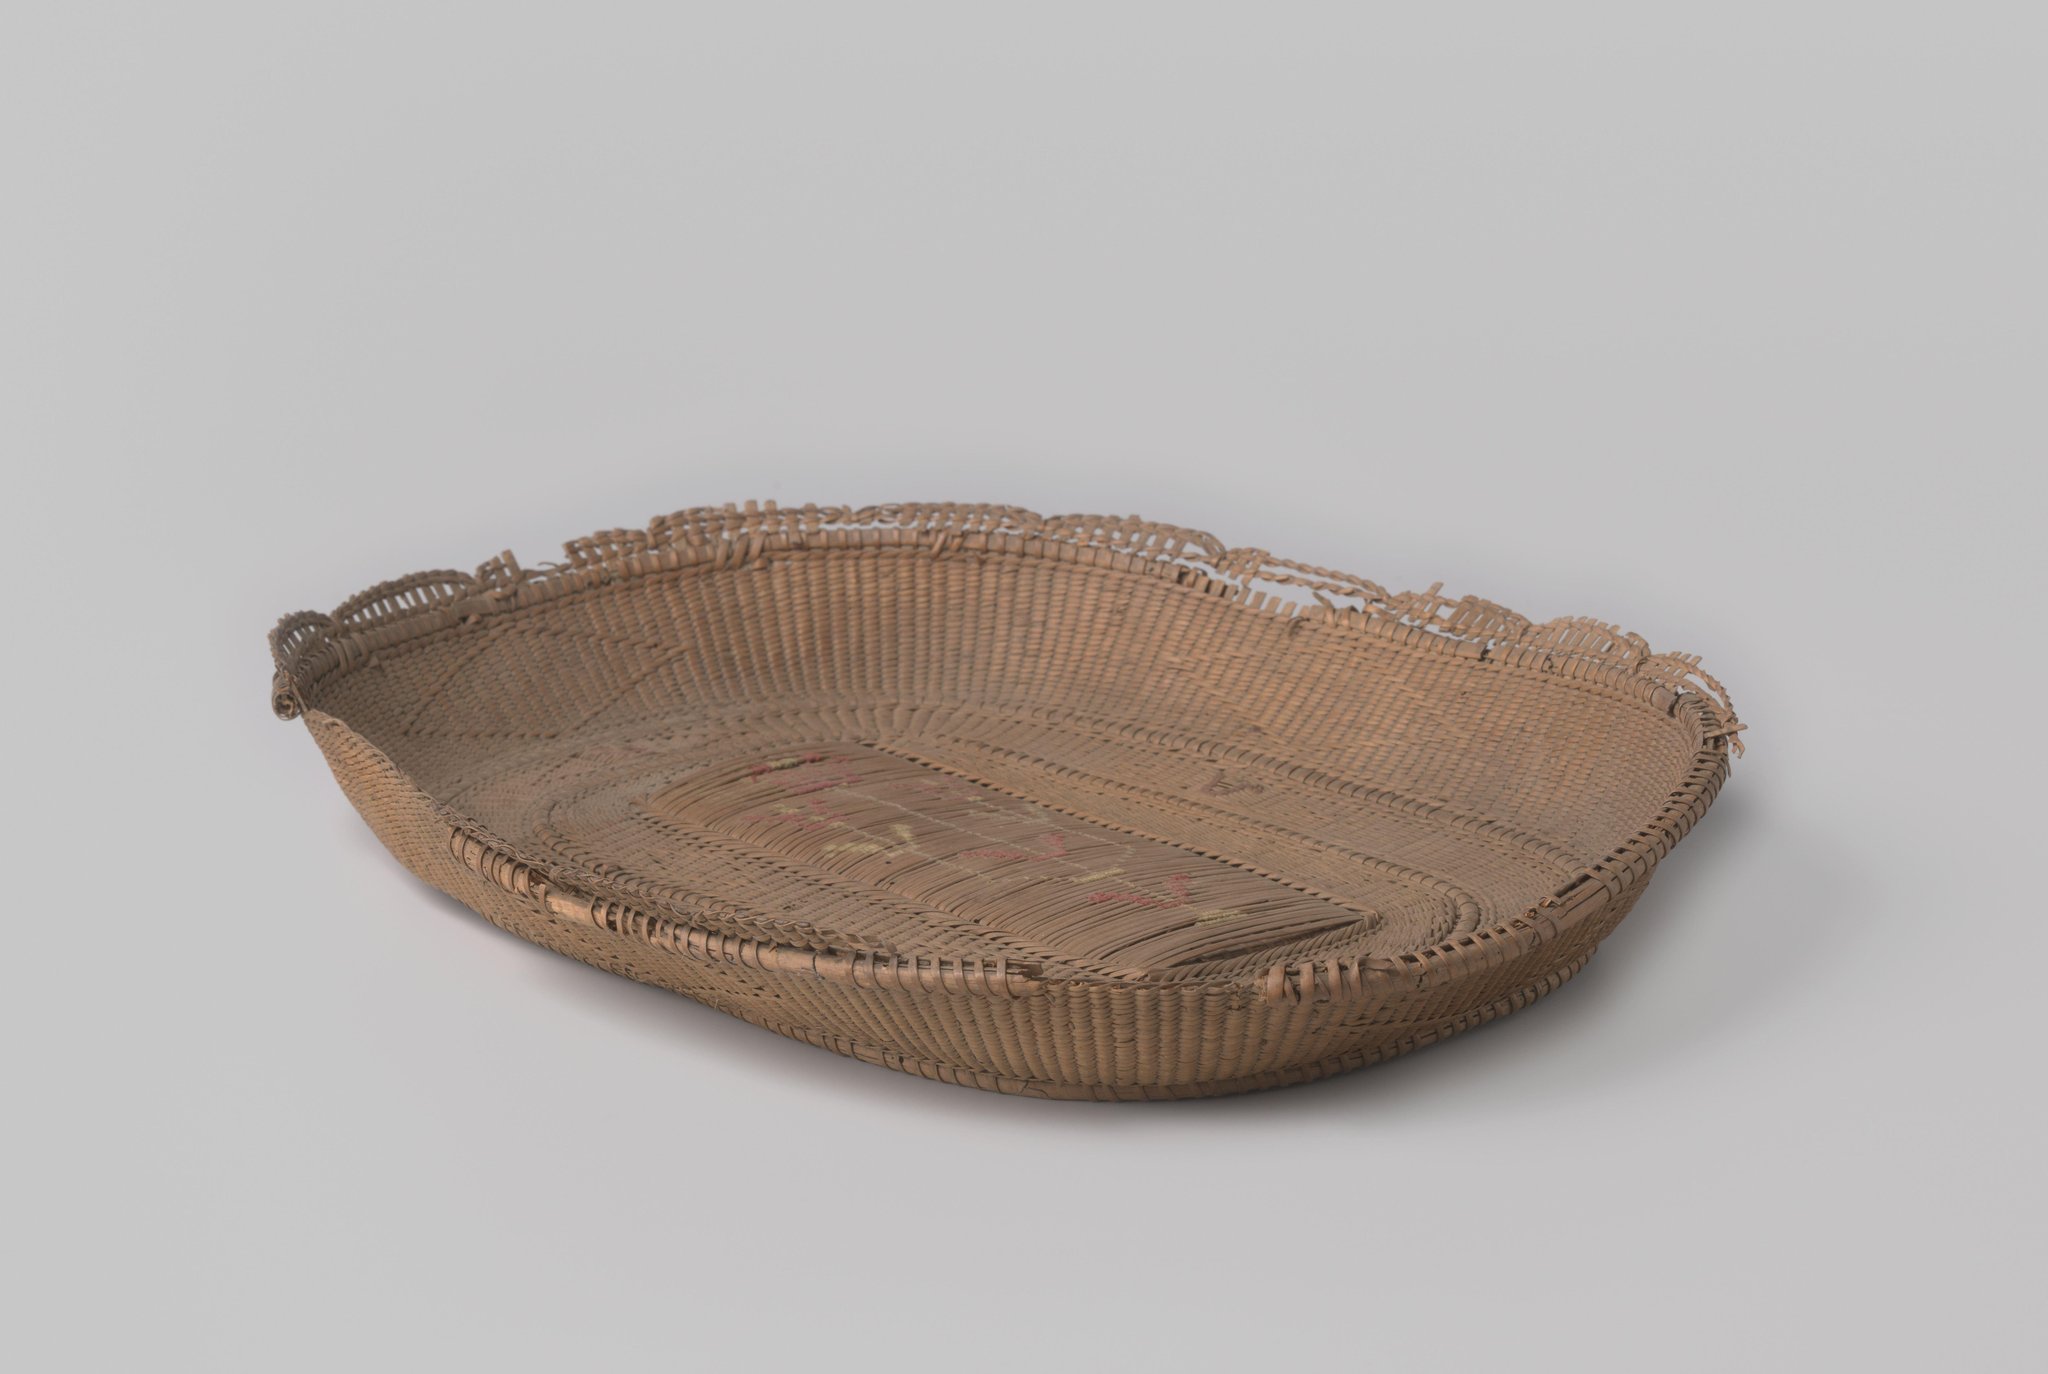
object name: basket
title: Platte mand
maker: Anonymous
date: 1700-1900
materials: reed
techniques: riet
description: Platte mand met op de bodem rode gevlochten tekens.